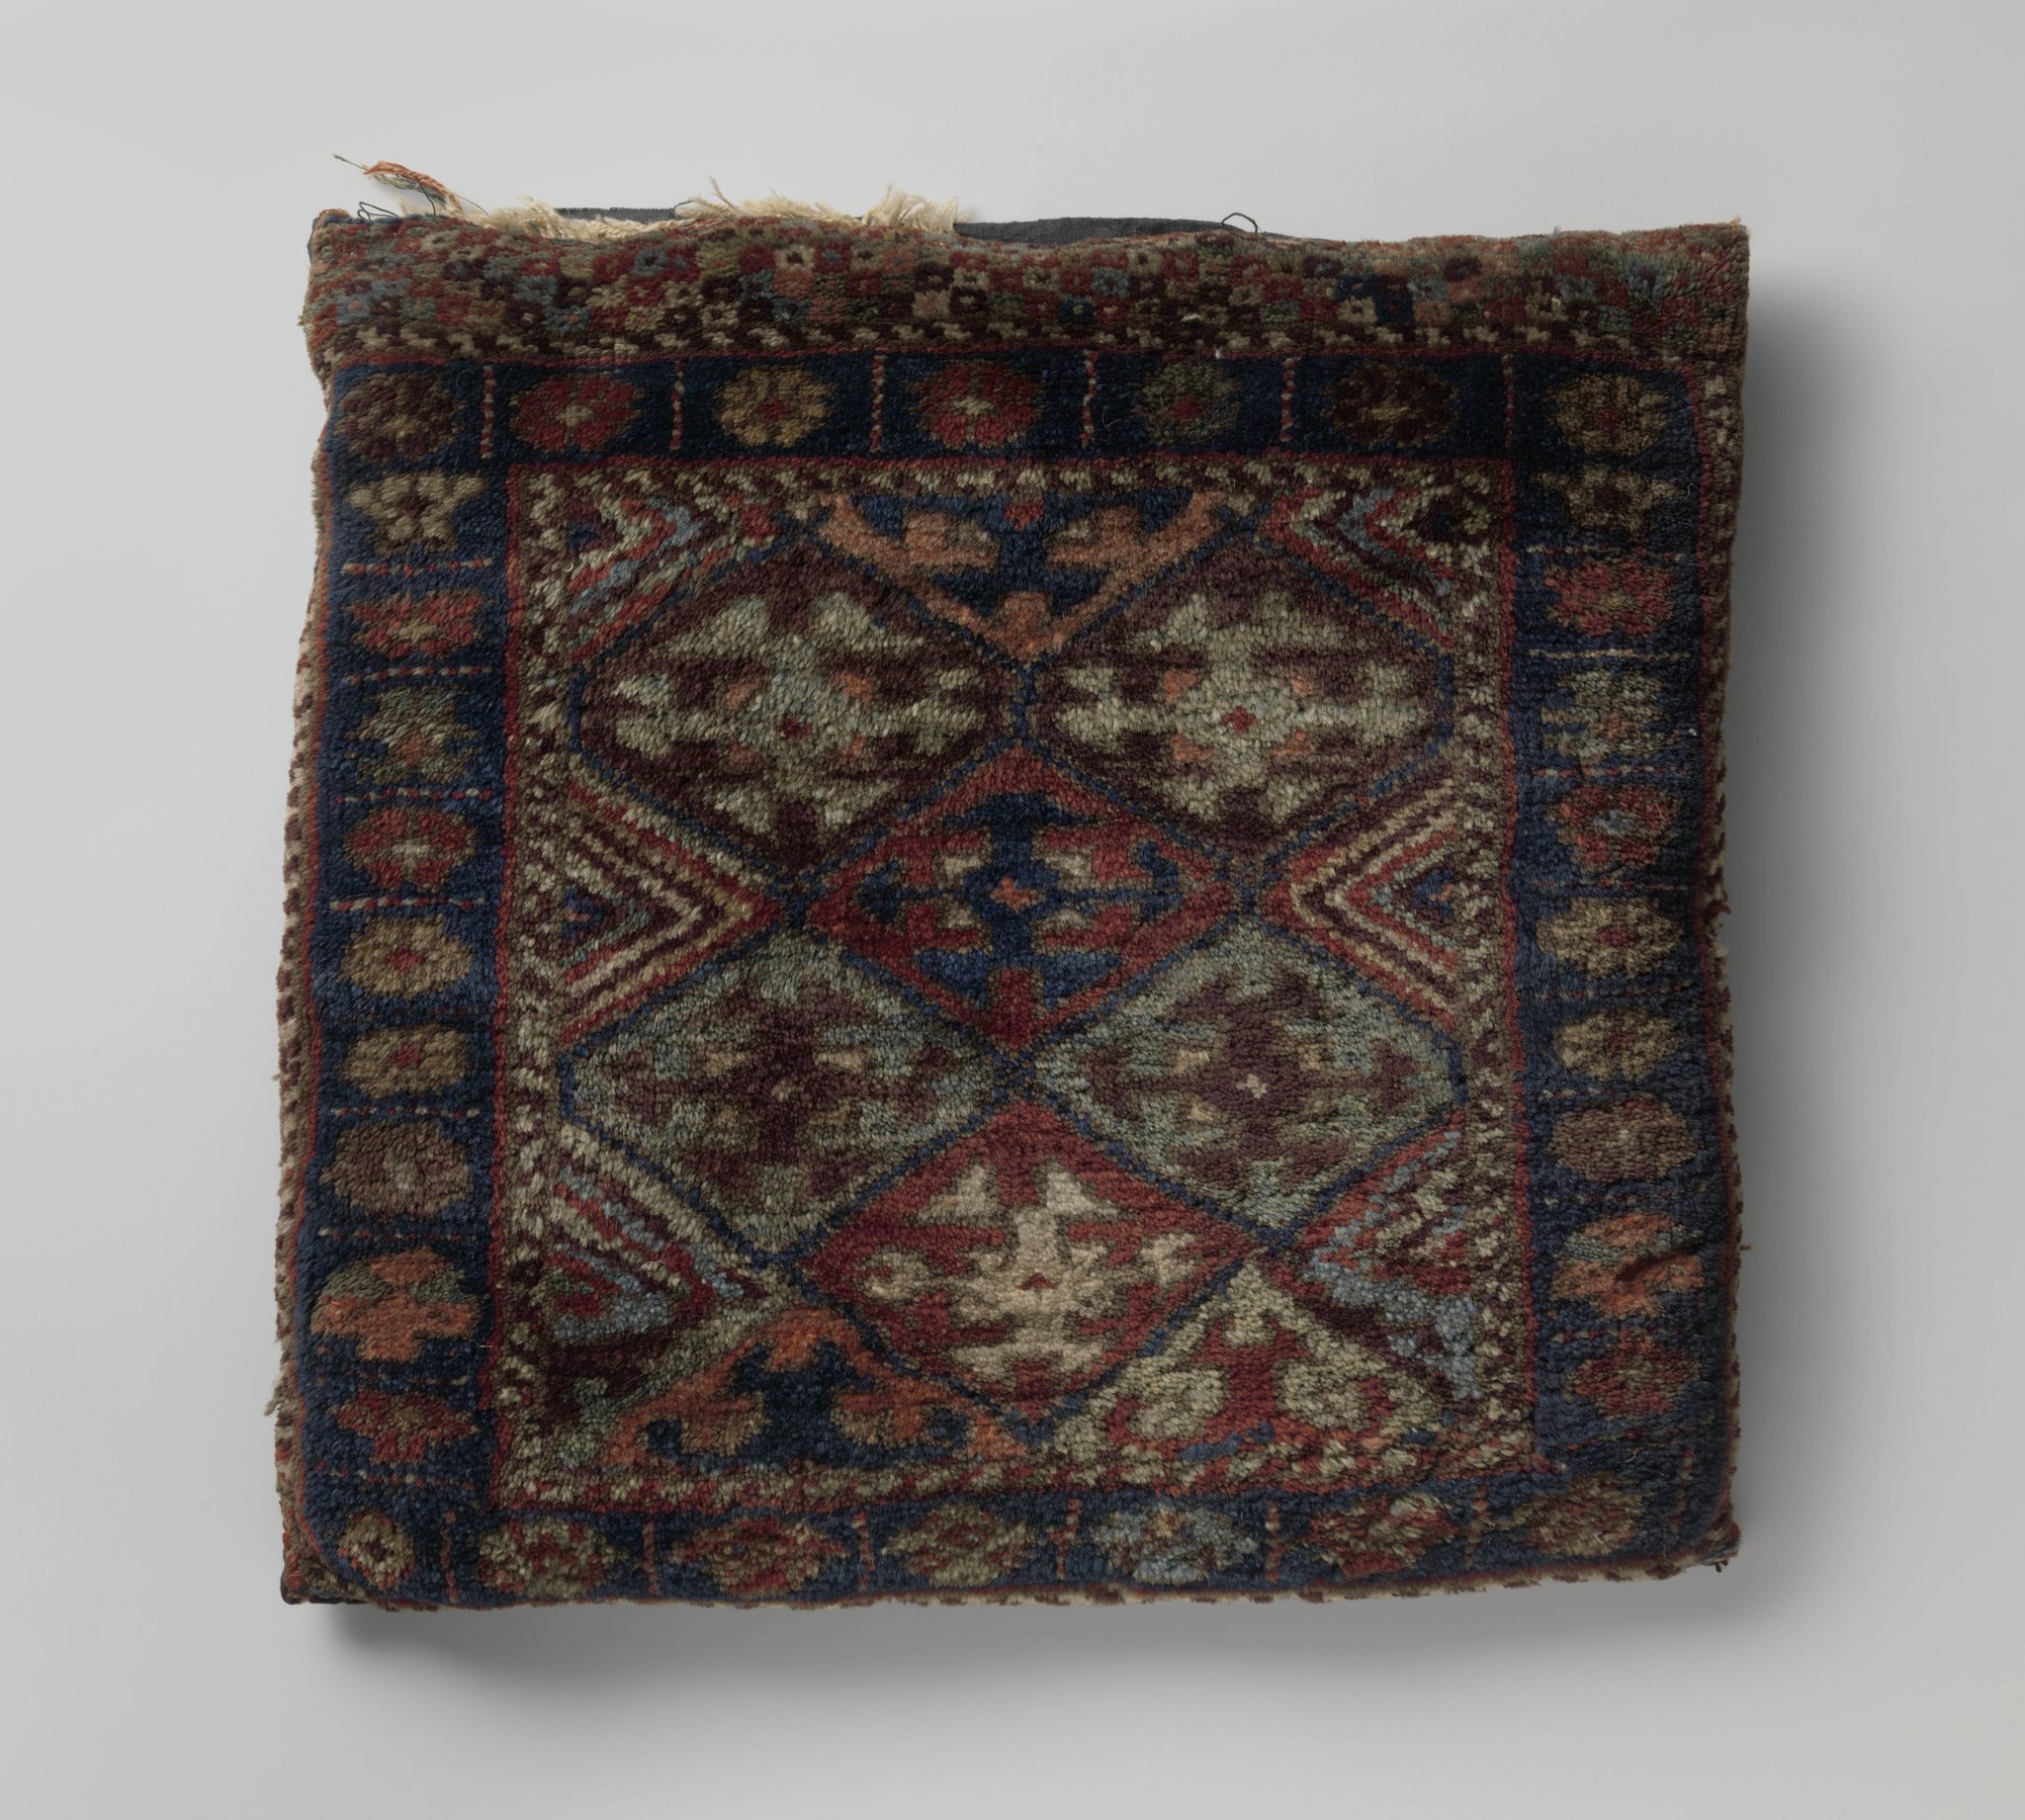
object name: voorblad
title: Voorblad zadeltas, versierd met rasterwerk waarbinnen kruisbloemen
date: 1800-1900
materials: wool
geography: kurdistan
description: Voorblad van een zadeltas, Jaffi Kurdistan-Mosul. Het middenveld is door een rasterwerk verdeeld in ruiten waarbinnen kruisbloemen. De halve ruiten terzijde zijn met concentrische ruitlijnen gevuld. Geblokte rand met rozetten. Aan twee zijden een geborduurde baard.